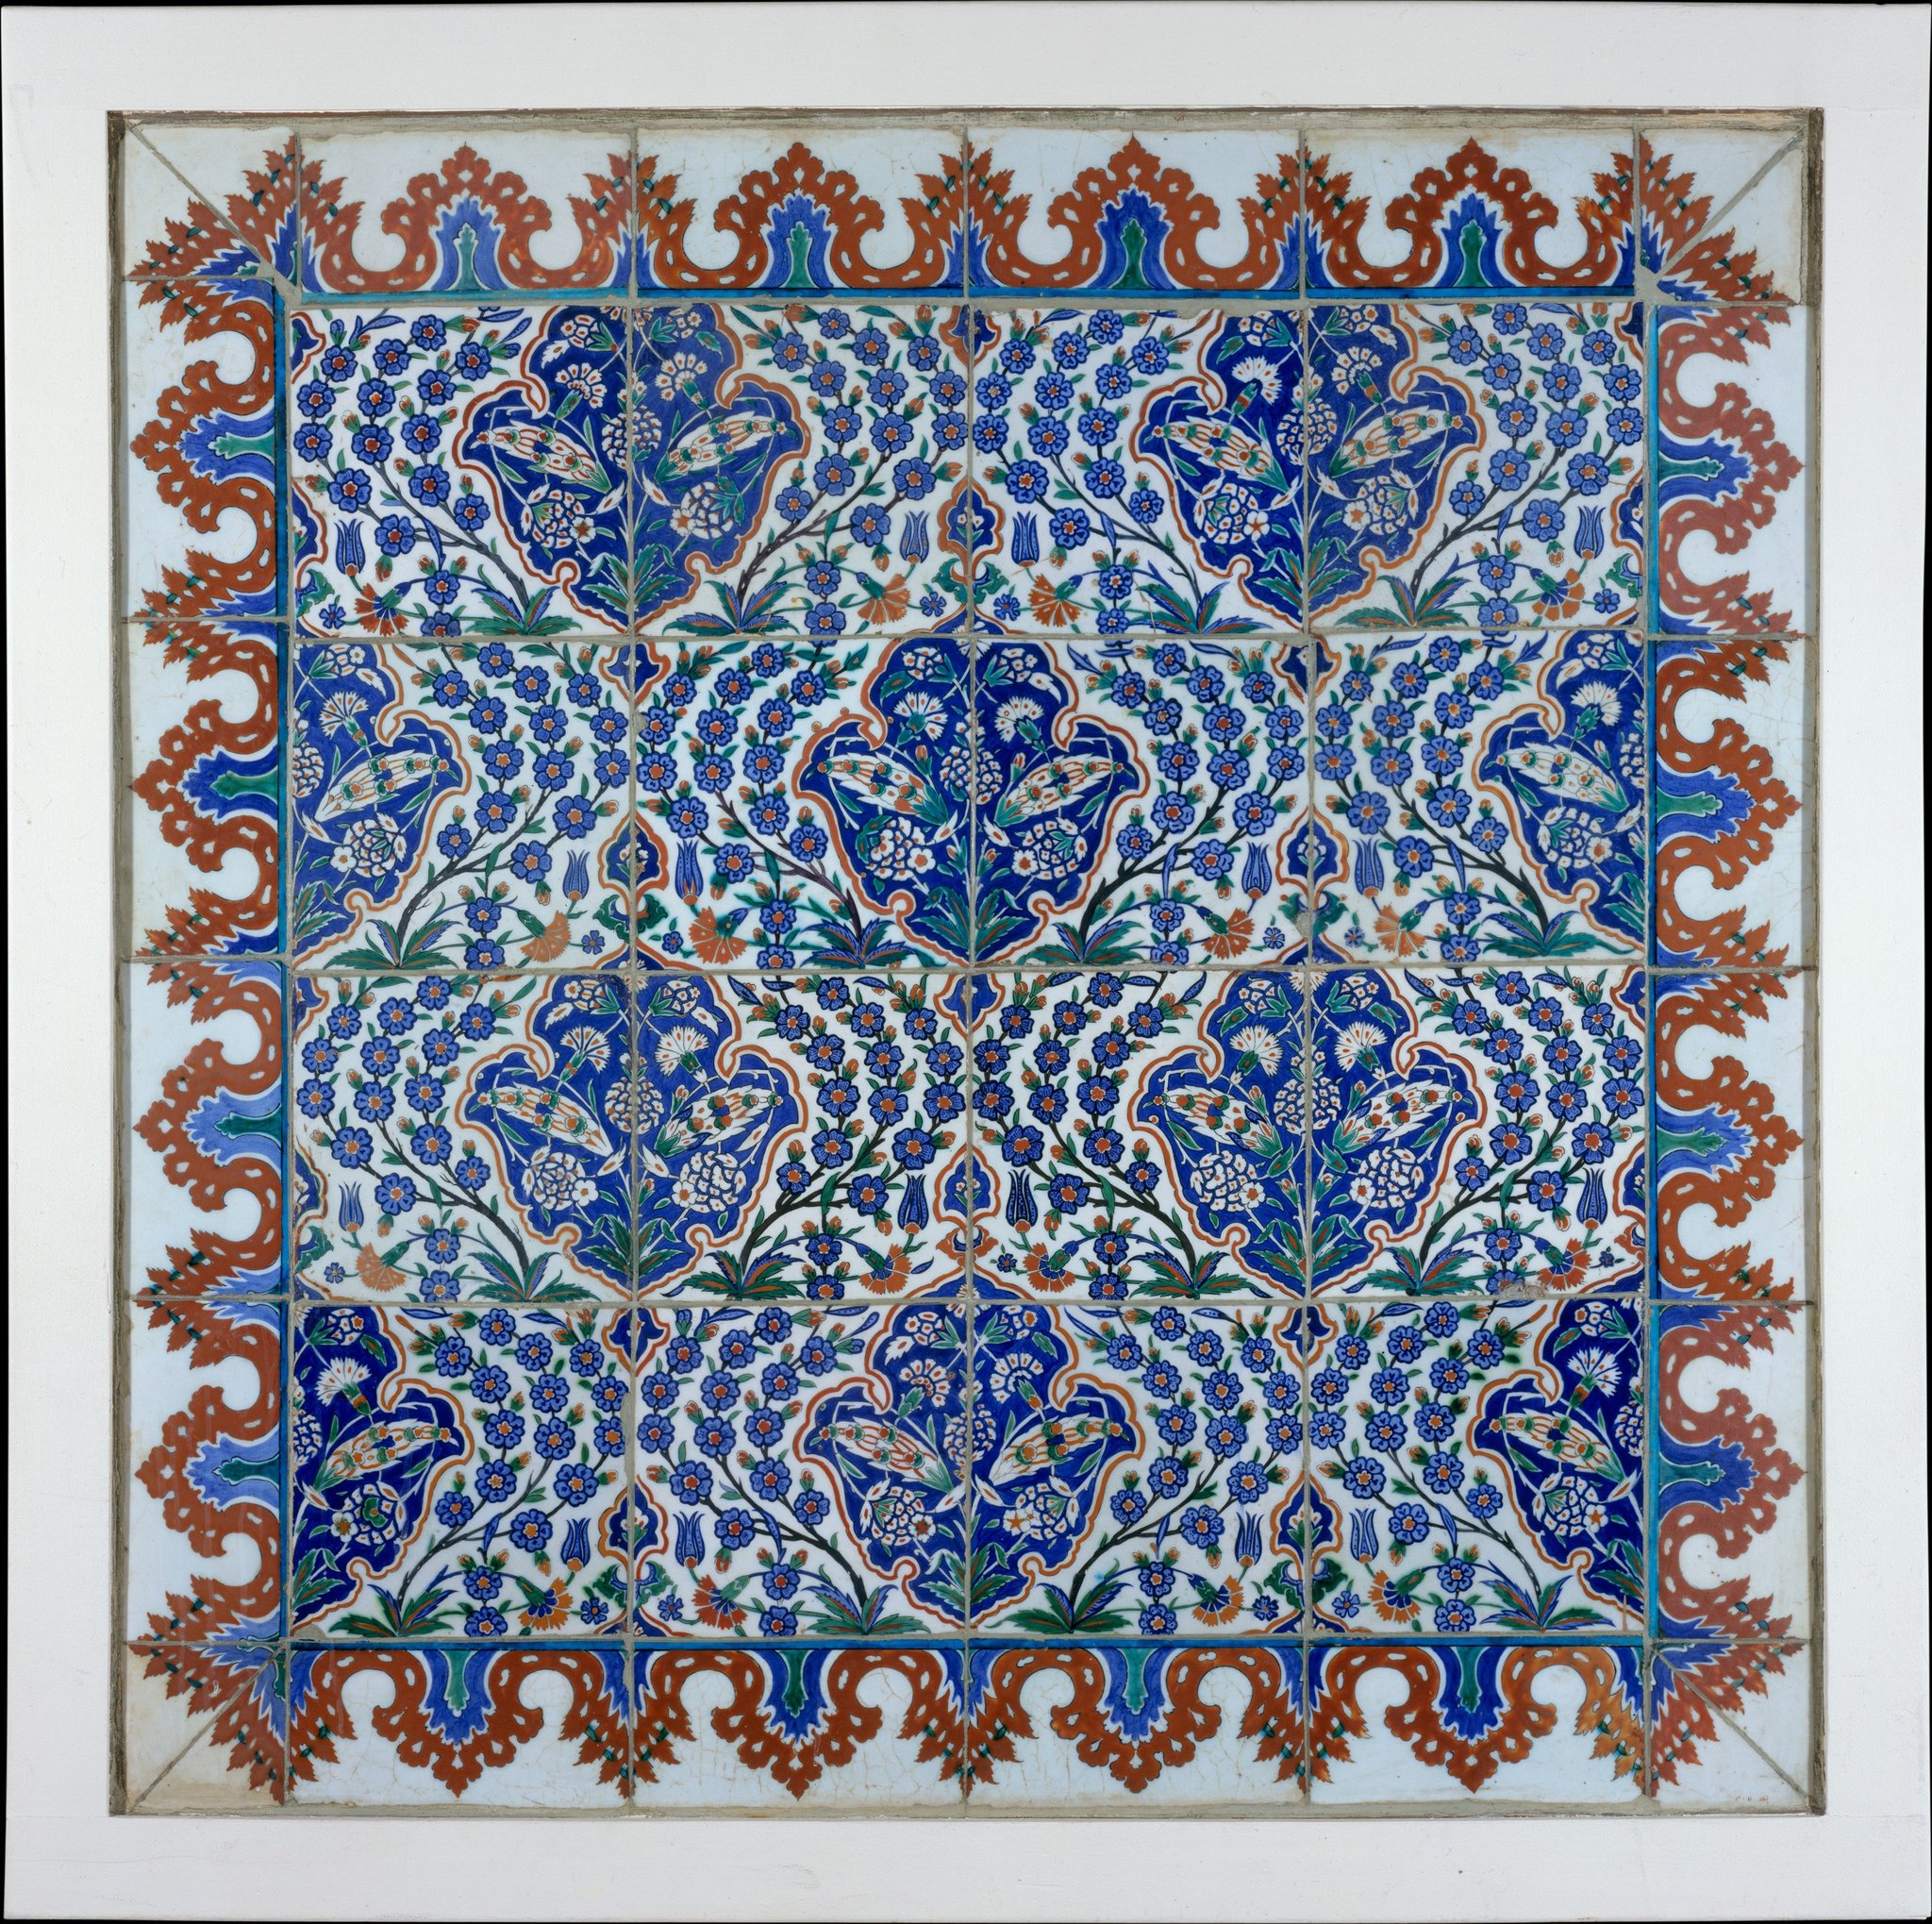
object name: tile panel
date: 1551-1600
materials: glaze, stonepaste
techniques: painting, polychrome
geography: turkey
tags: flowers,leaves